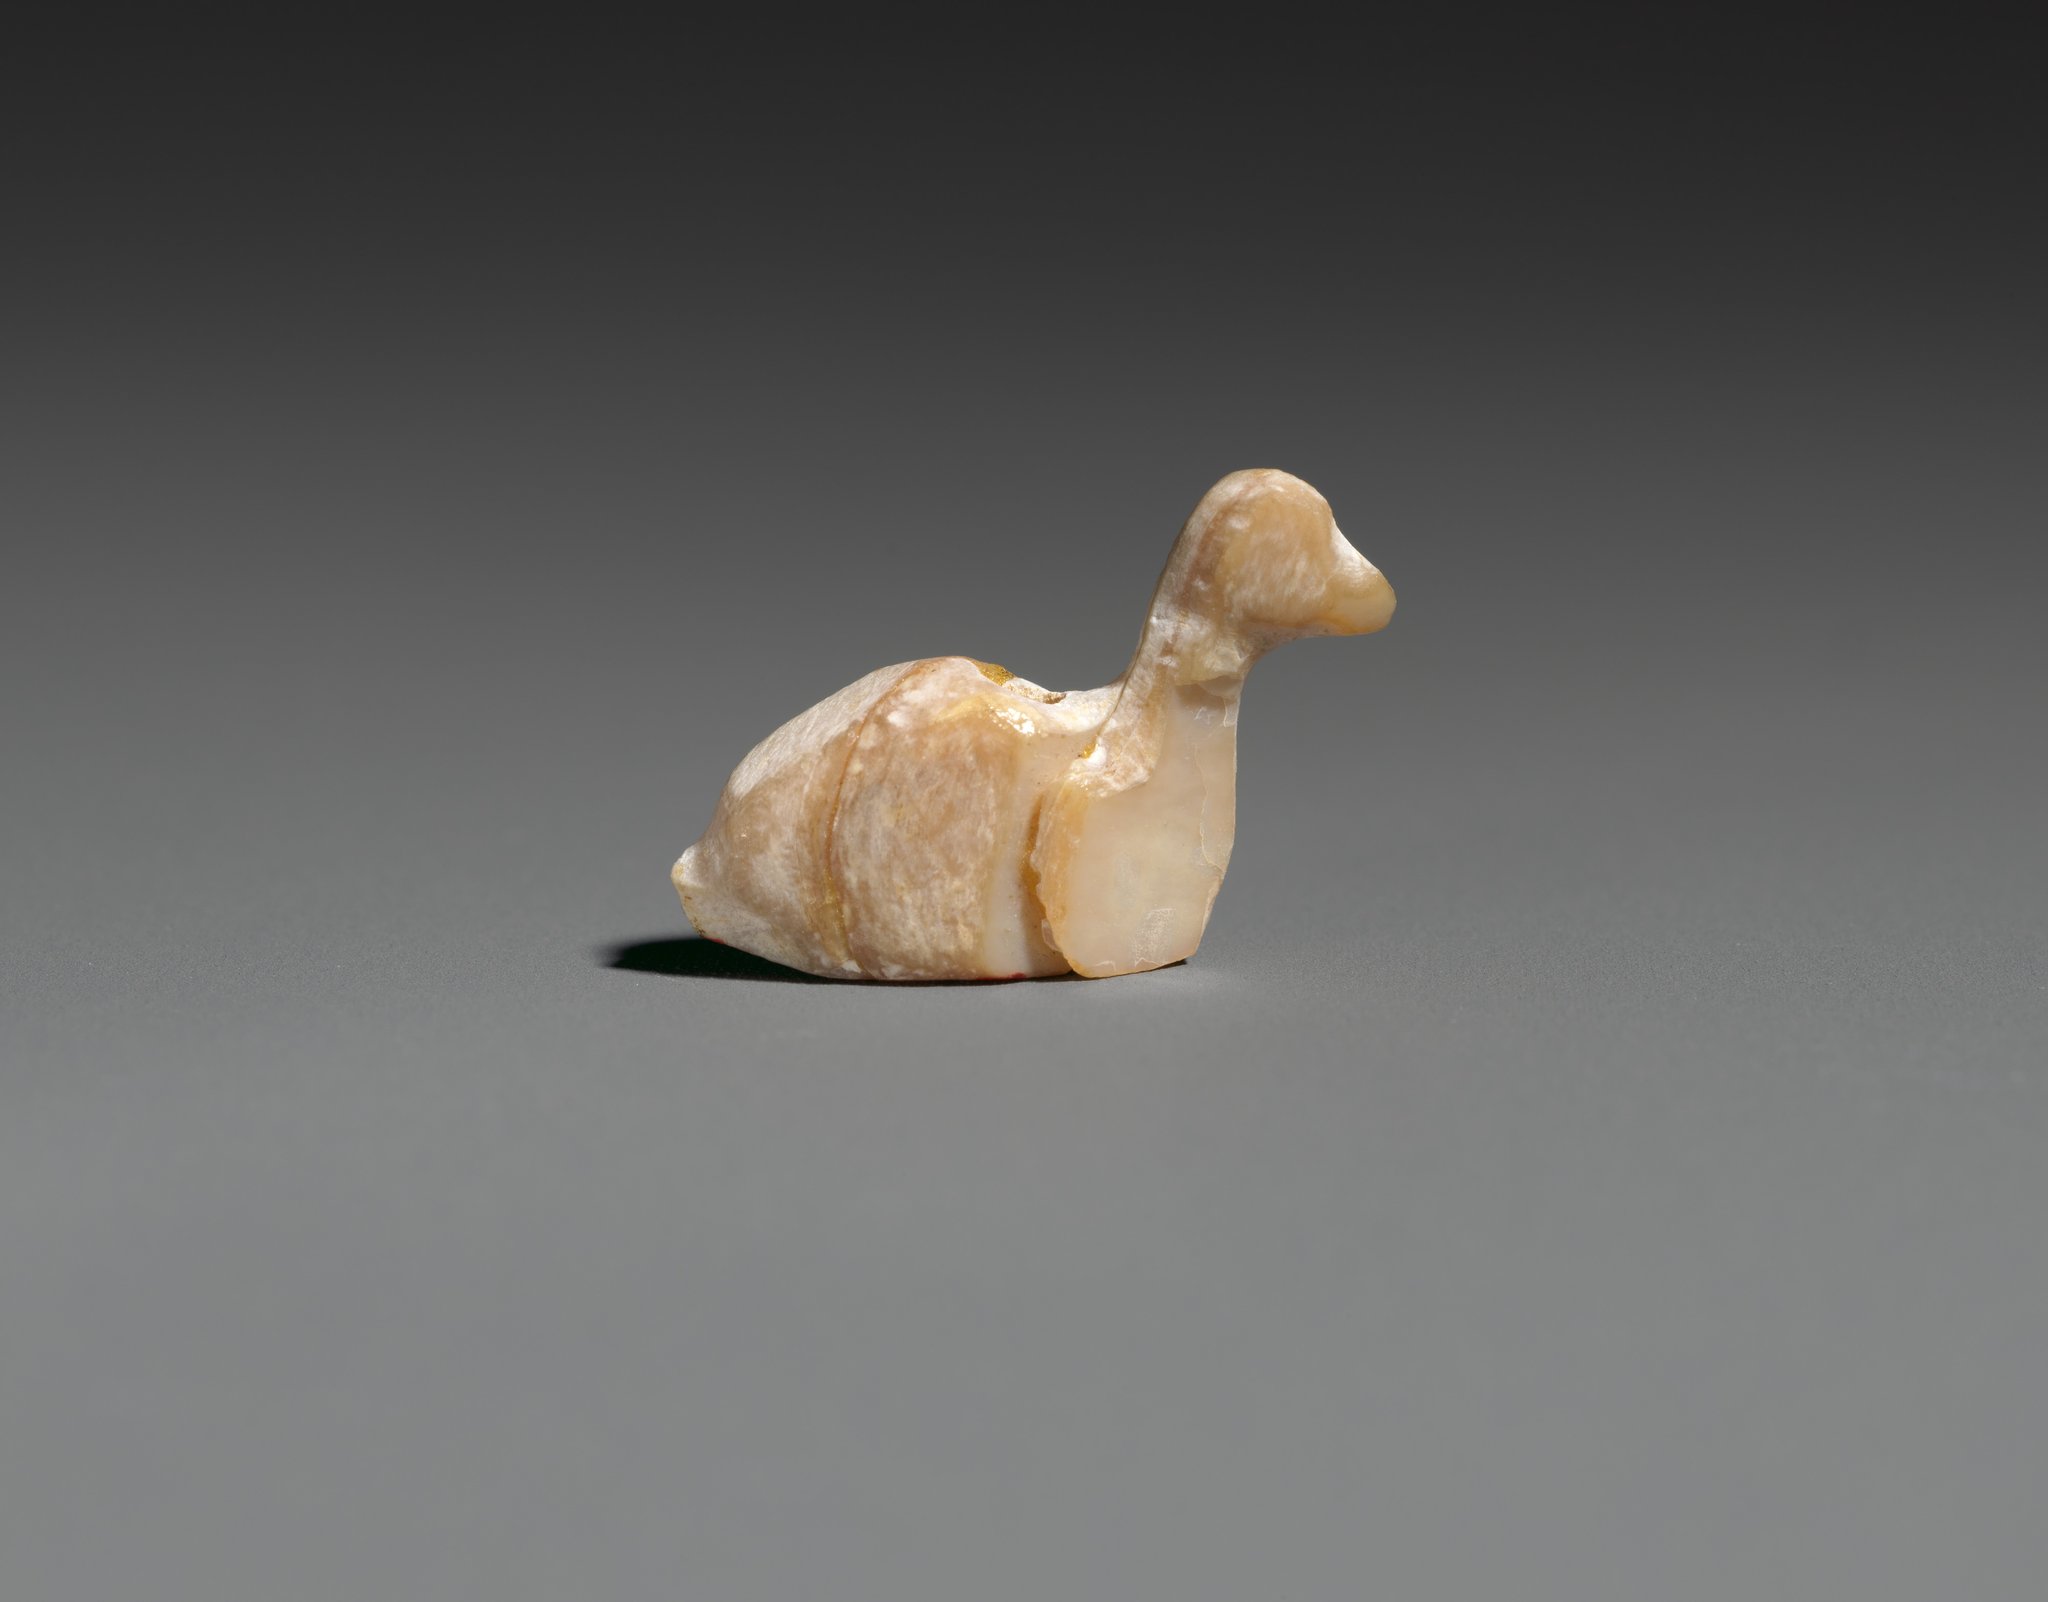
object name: necklace, bead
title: Duck amulet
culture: sumerian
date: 2700-2600 BCE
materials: shell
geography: mesopotamia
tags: ducks